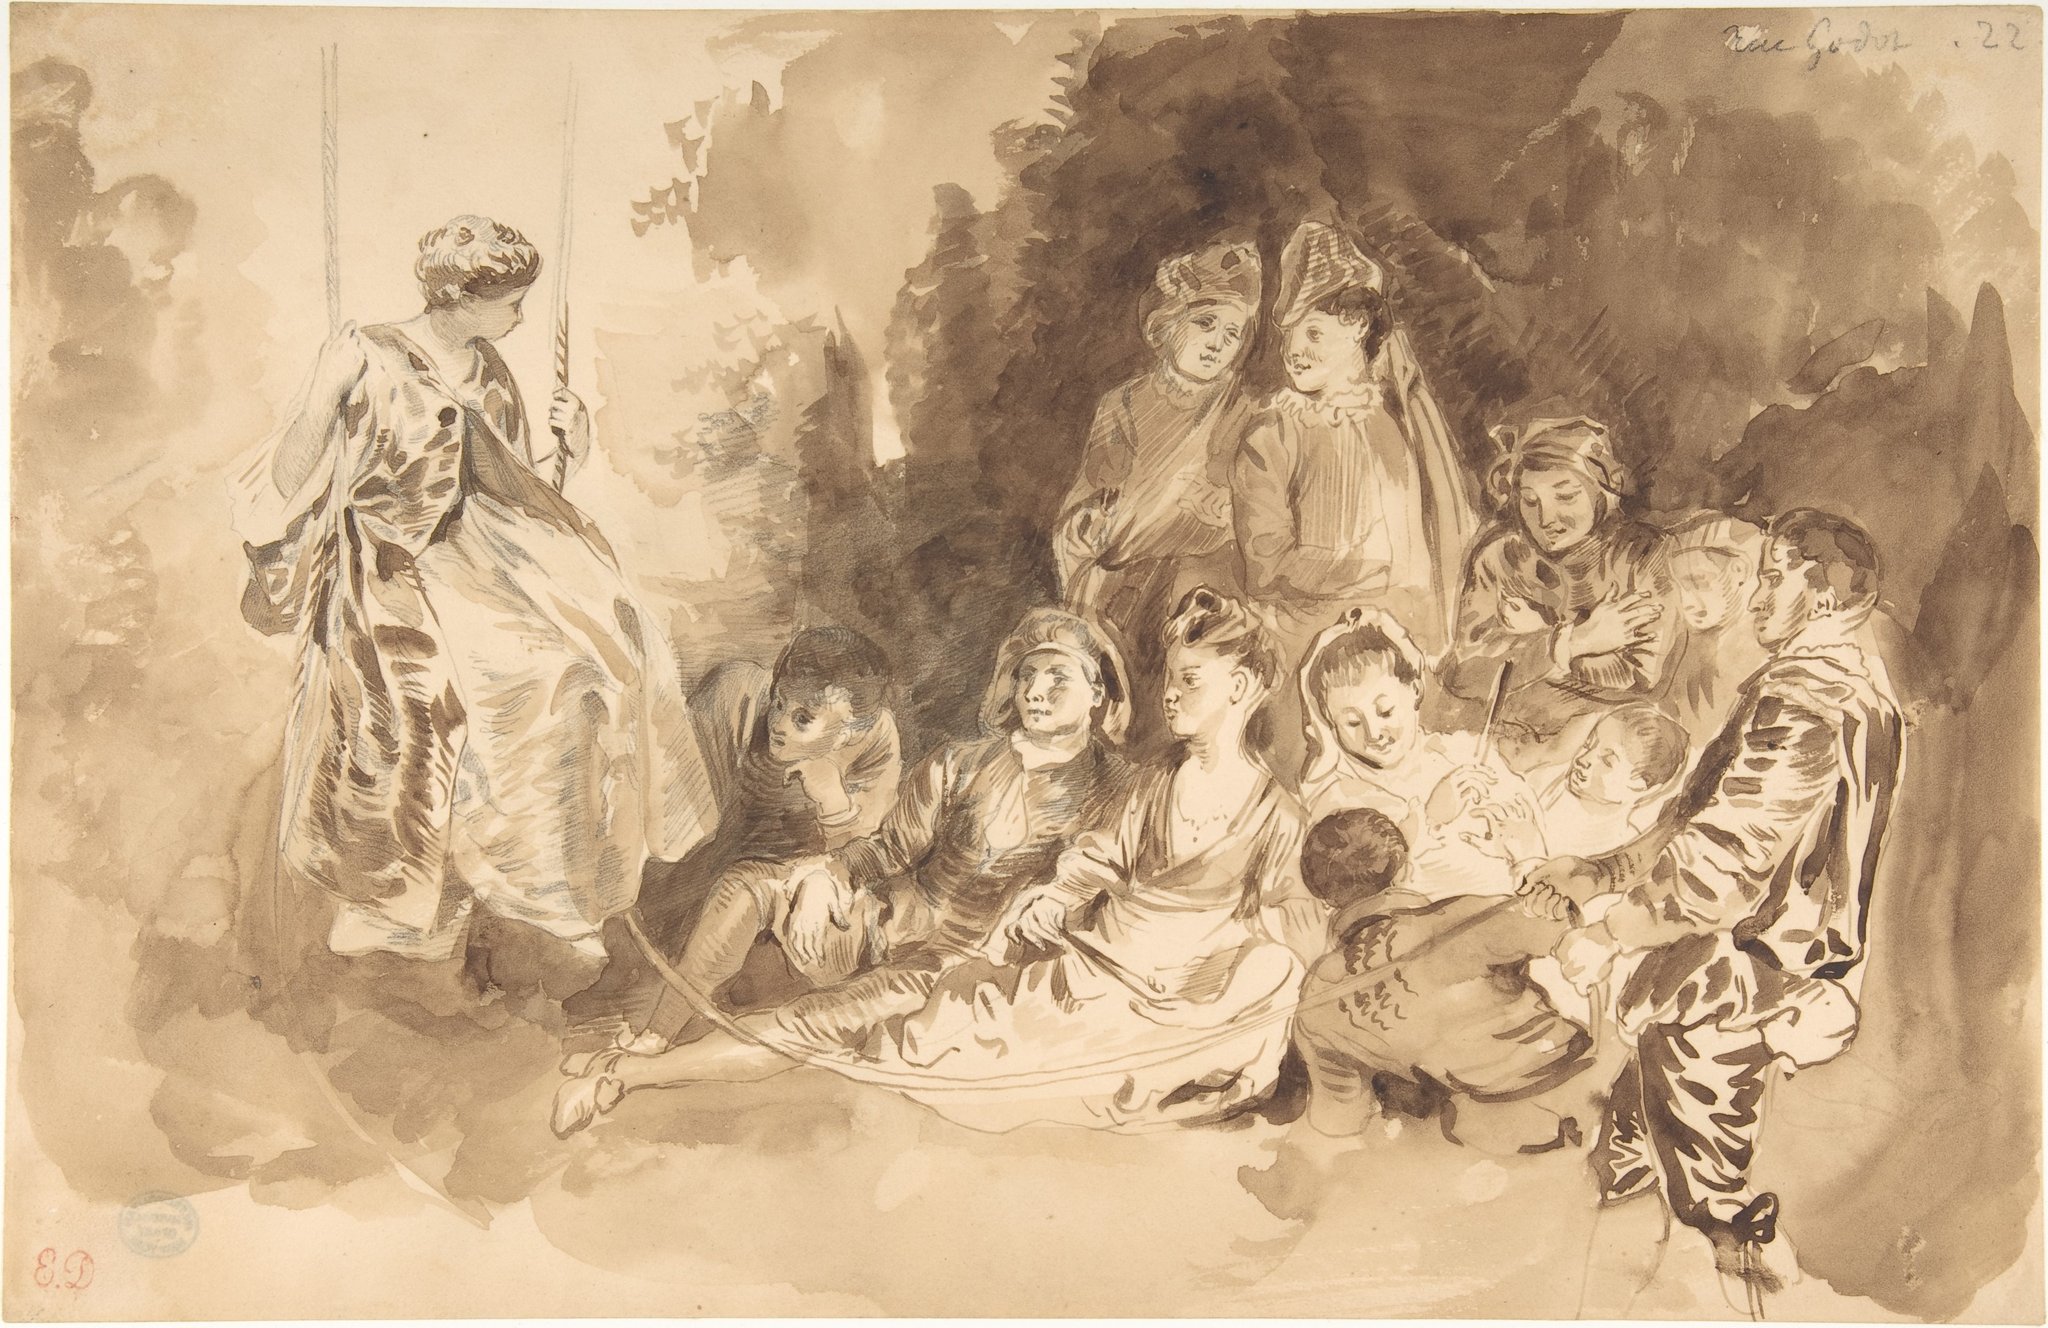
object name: drawing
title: "The Swing," after Antoine Watteau (Les Agréements de l'été)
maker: eugène delacroix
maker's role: artist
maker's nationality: french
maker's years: 1798-1863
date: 1798-1863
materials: graphite, paper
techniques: brush, wash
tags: men,women